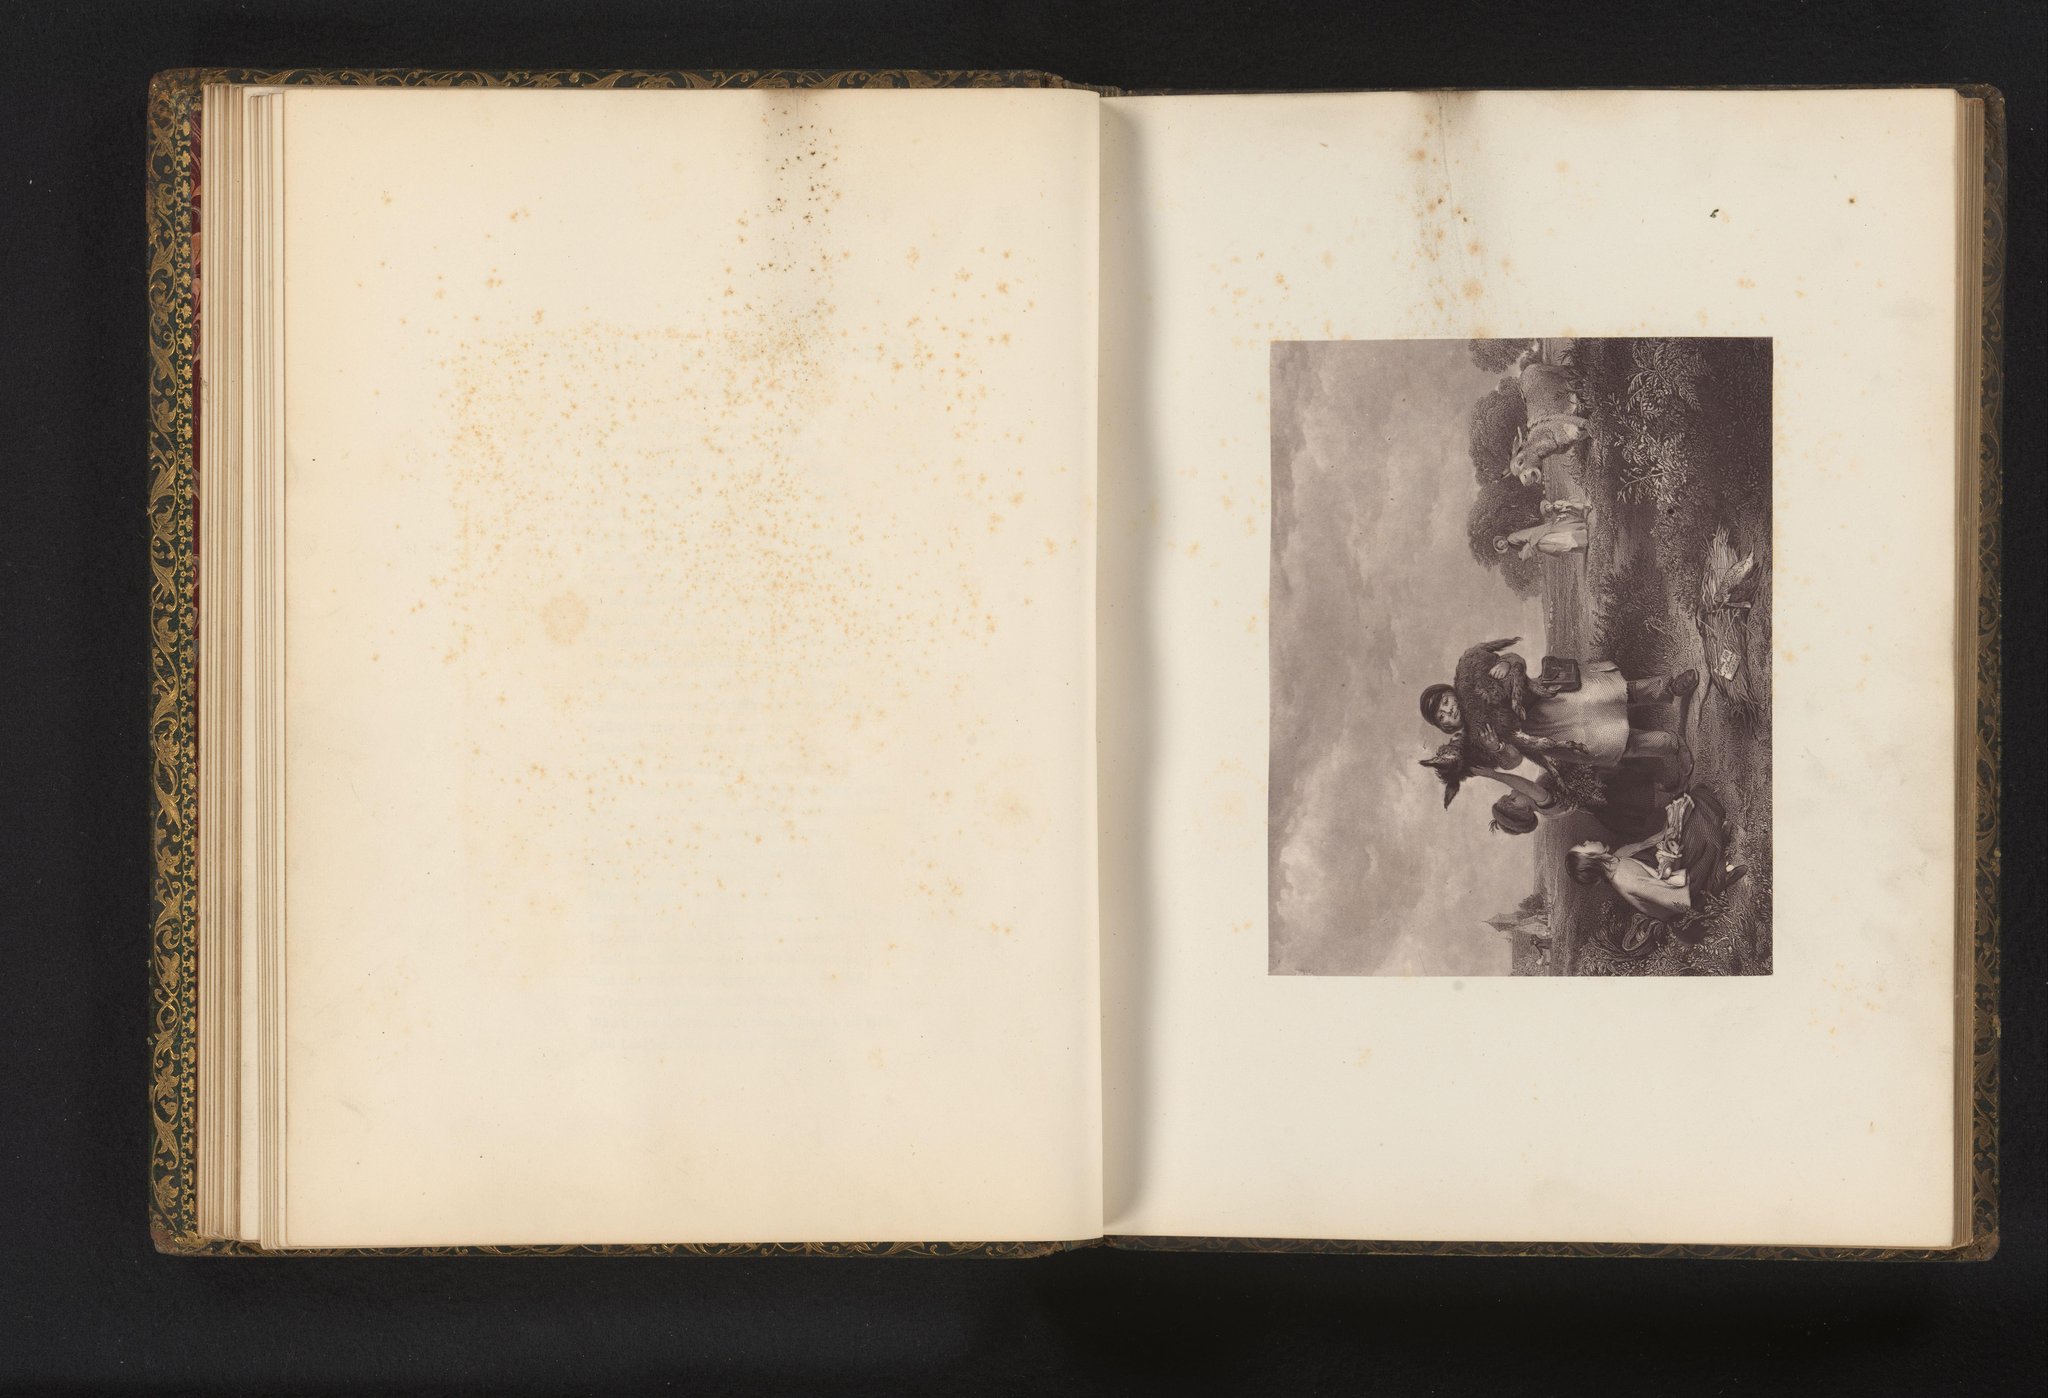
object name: photomechanical print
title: Fotoreproductie van een gravure naar het schilderij The pet of the common door John Callcott Horsley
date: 1866-1871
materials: paper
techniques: woodburytype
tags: ass, donkey, print, e.g.: engraving, etching, lithograph, child, meadow, pasture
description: Prent op derde ongenummerde pagina na pagina 34.